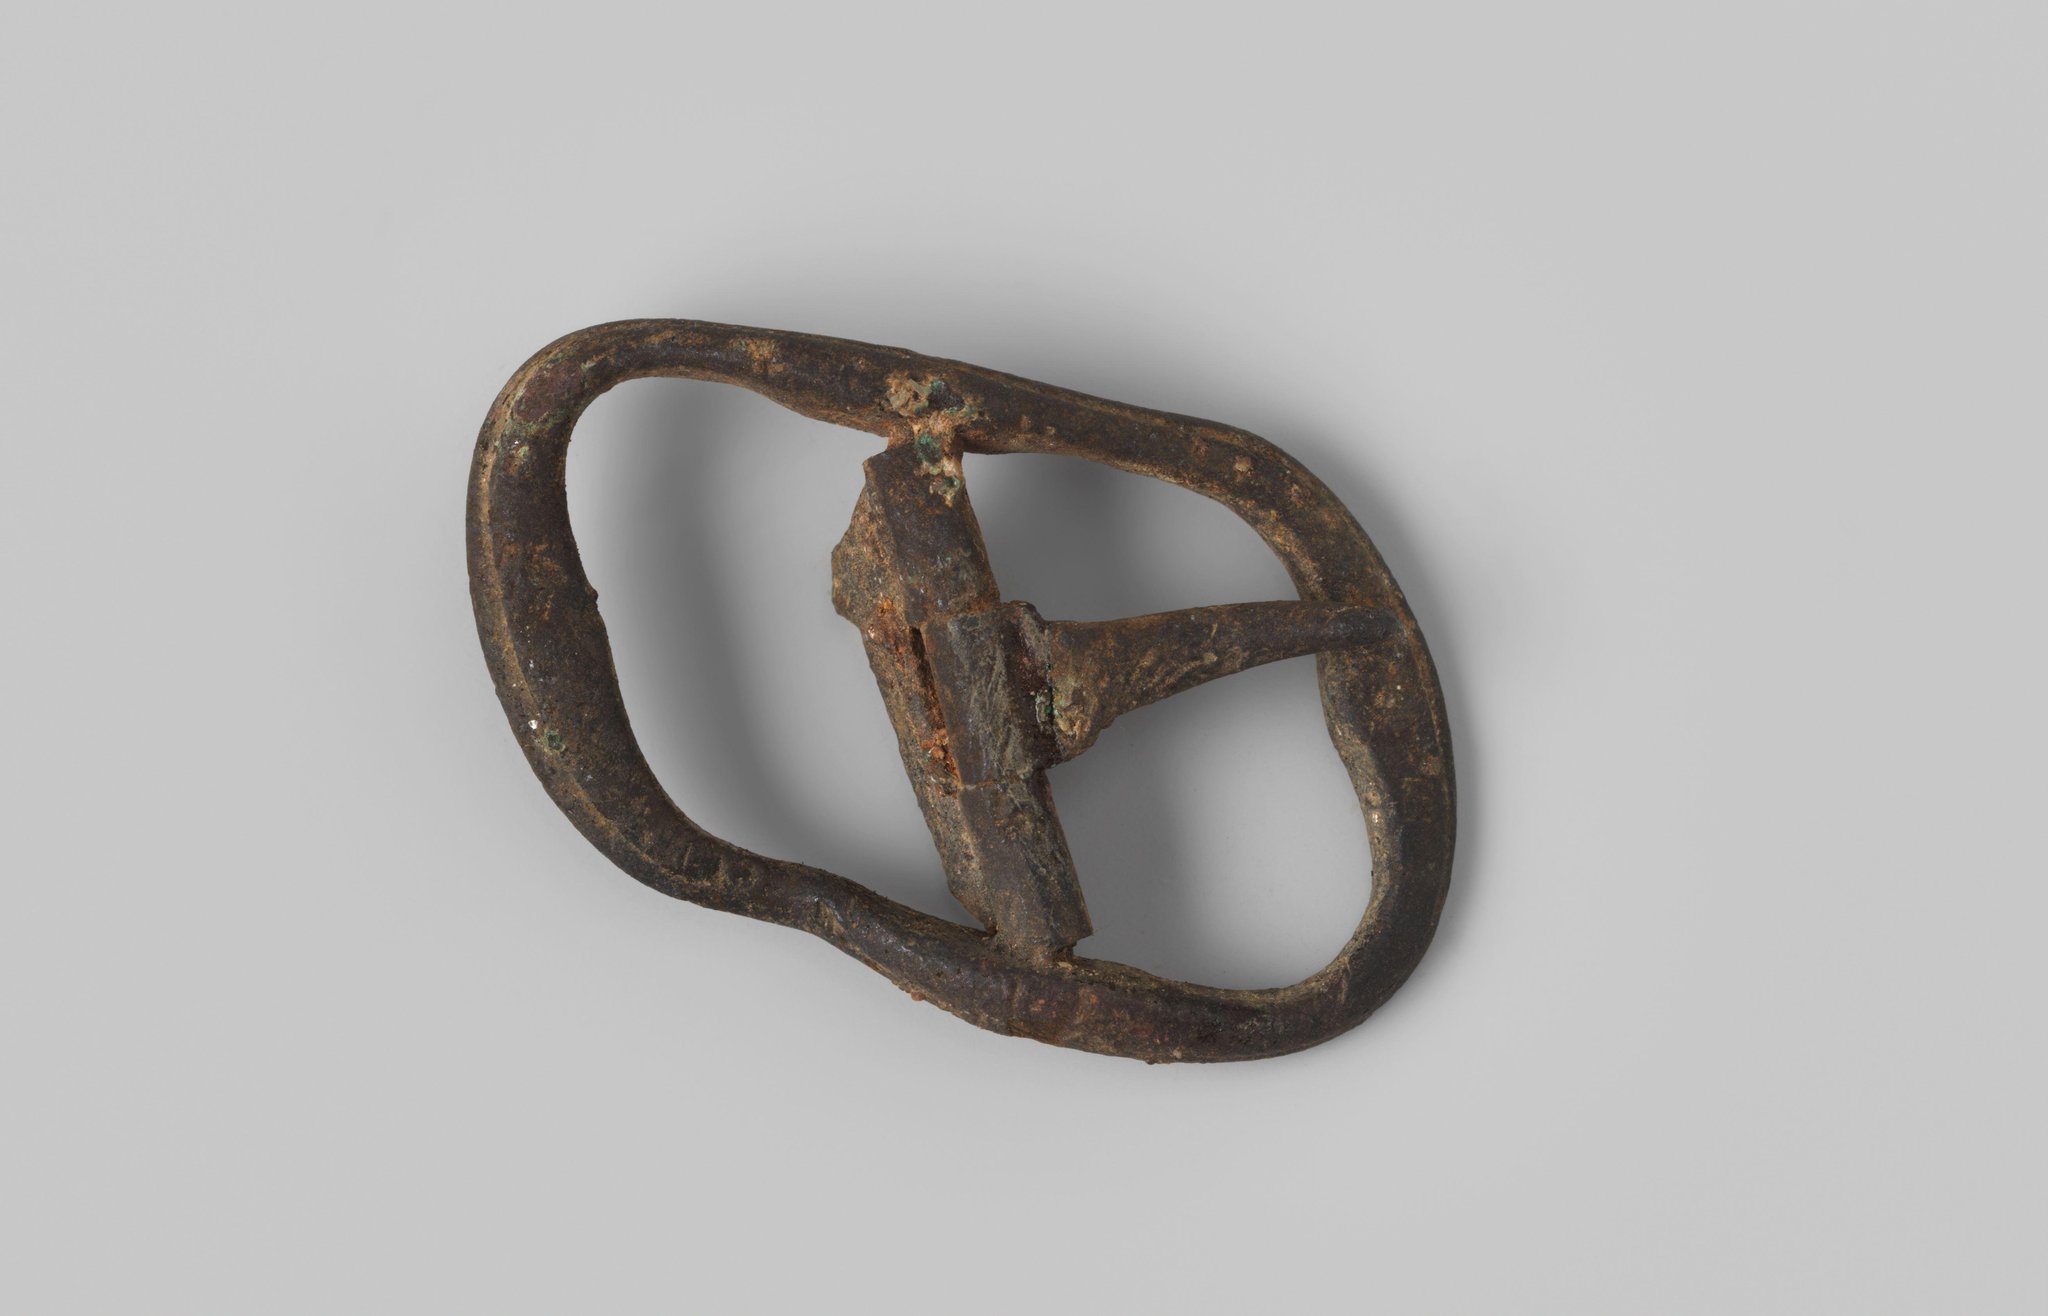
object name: shoe buckle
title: Schoengesp uit het wrak van de Oost-Indiëvaarder Hollandia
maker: Anonymous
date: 1700-1743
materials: copper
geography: netherlands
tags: verenigde oostindische compagnie, hollandia (schip), annet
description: Buckle, chape buckle, shoe buckle; ring, id. NG 1980-27H2930, with tongue, loop missing.